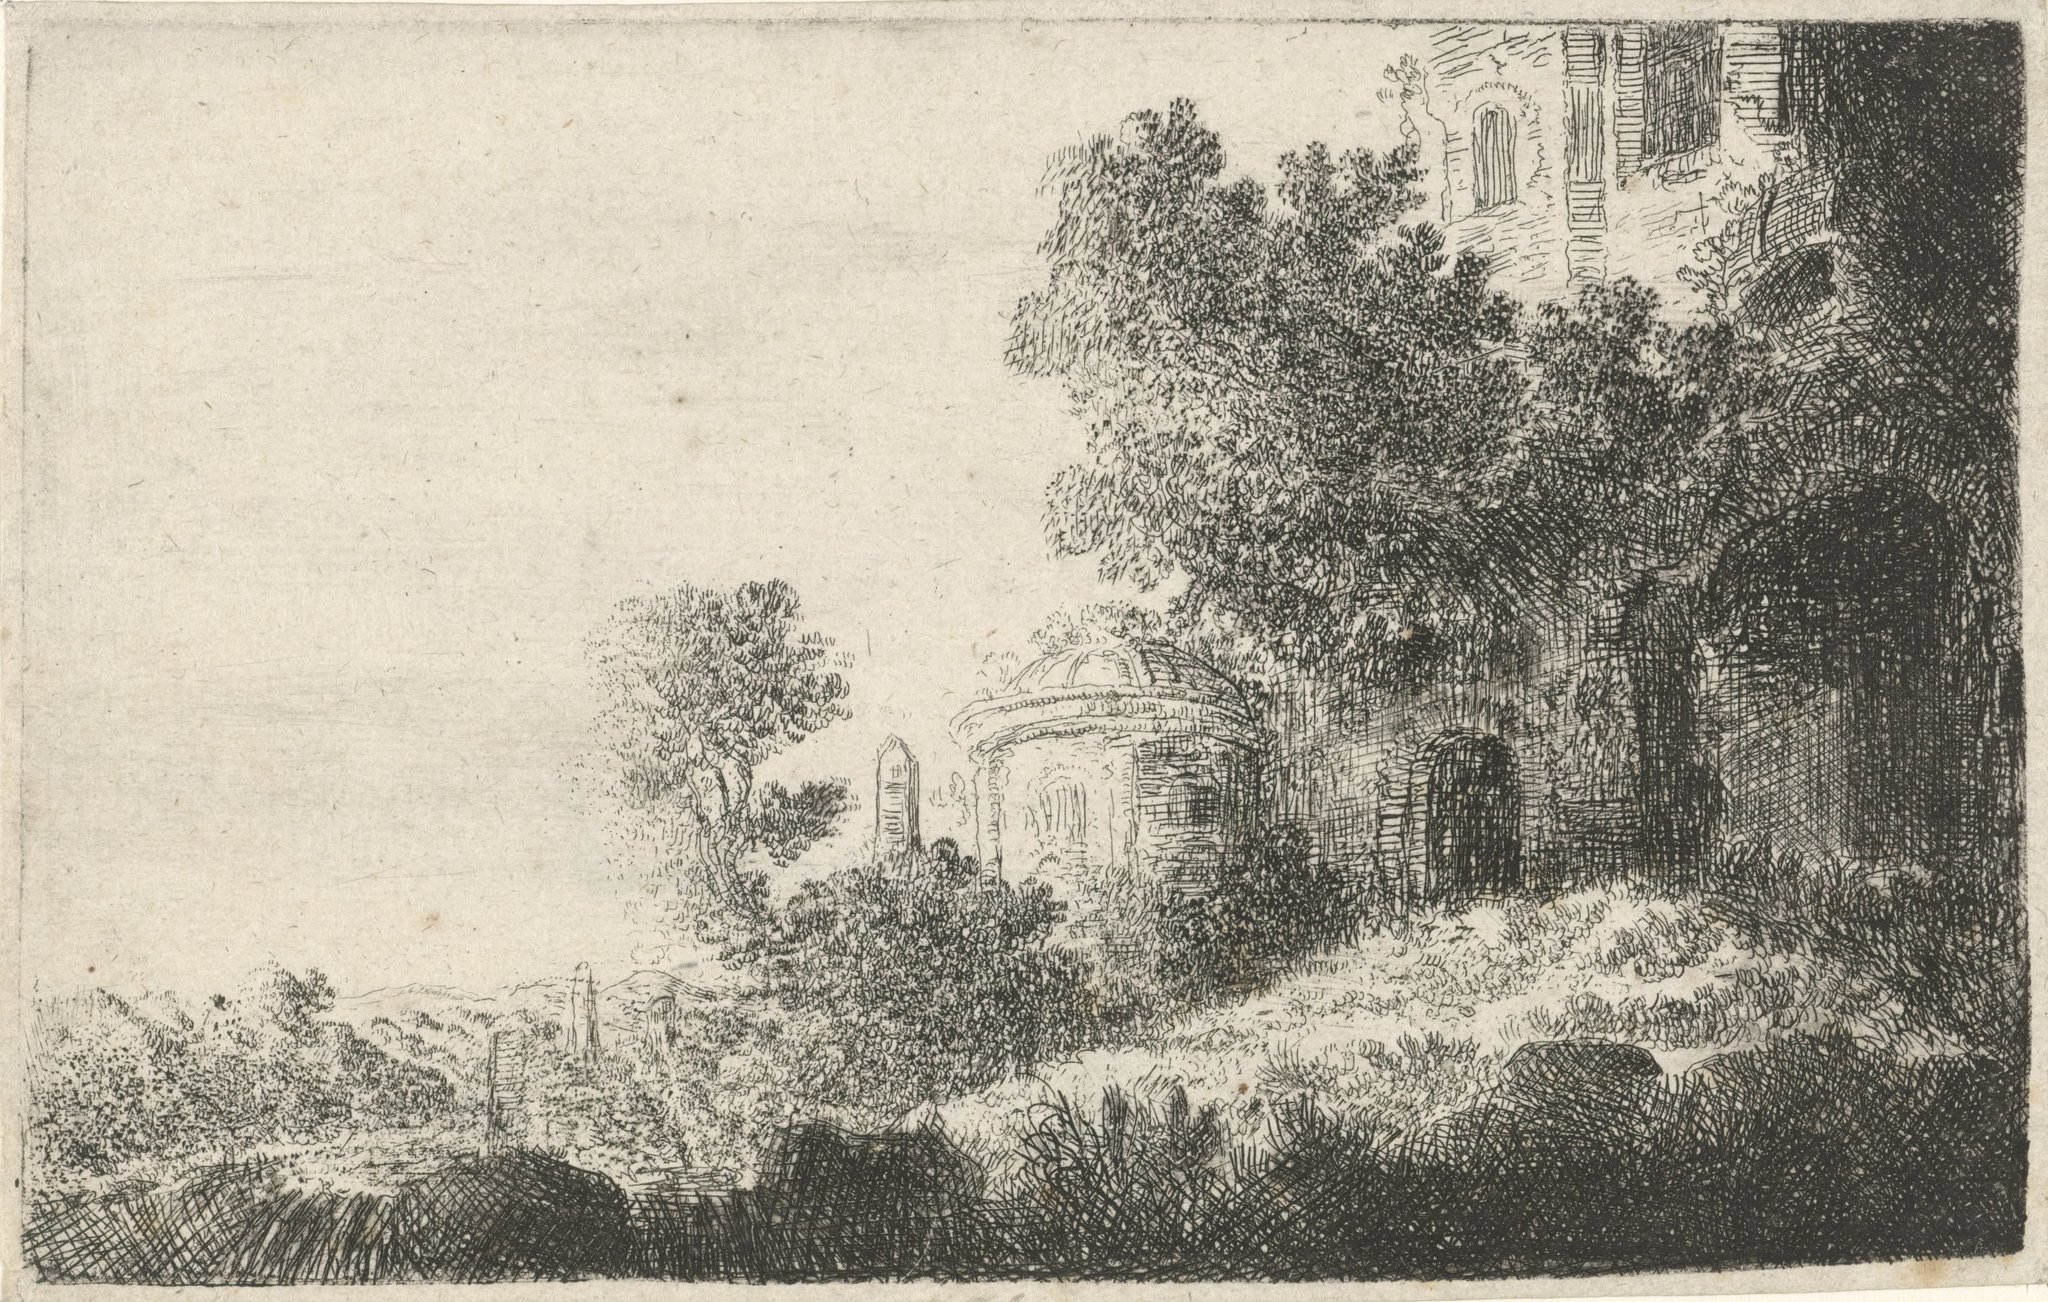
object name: print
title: Landschap met rechts gebouwen tussen bomen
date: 1612-1655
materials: paper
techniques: engraving, etching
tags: trees, obelisk, needle, landscapes in the temperate zone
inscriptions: collector's mark: Lugt 240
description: Landschap met rechts enkele gebouwen op een heuvel. In de achtergrond een obelisk.